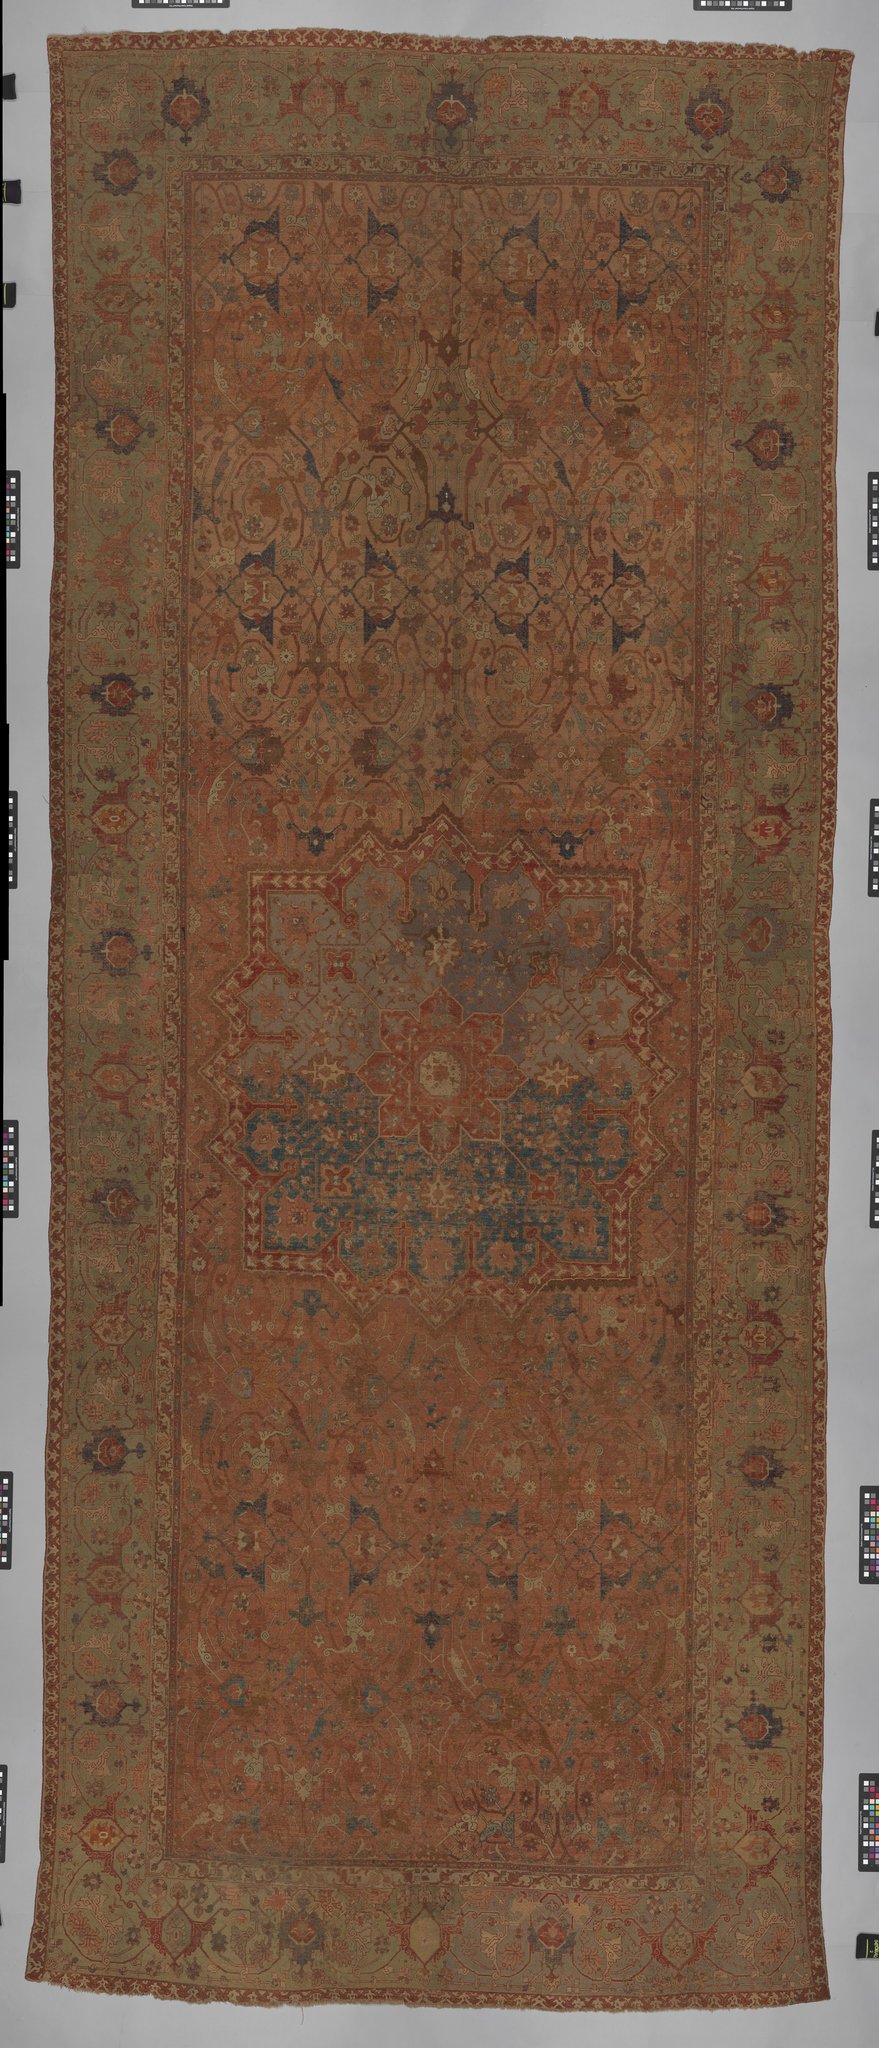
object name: carpet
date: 1501-1600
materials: cotton, wool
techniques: asymmetrically knotted pile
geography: northwestern iran